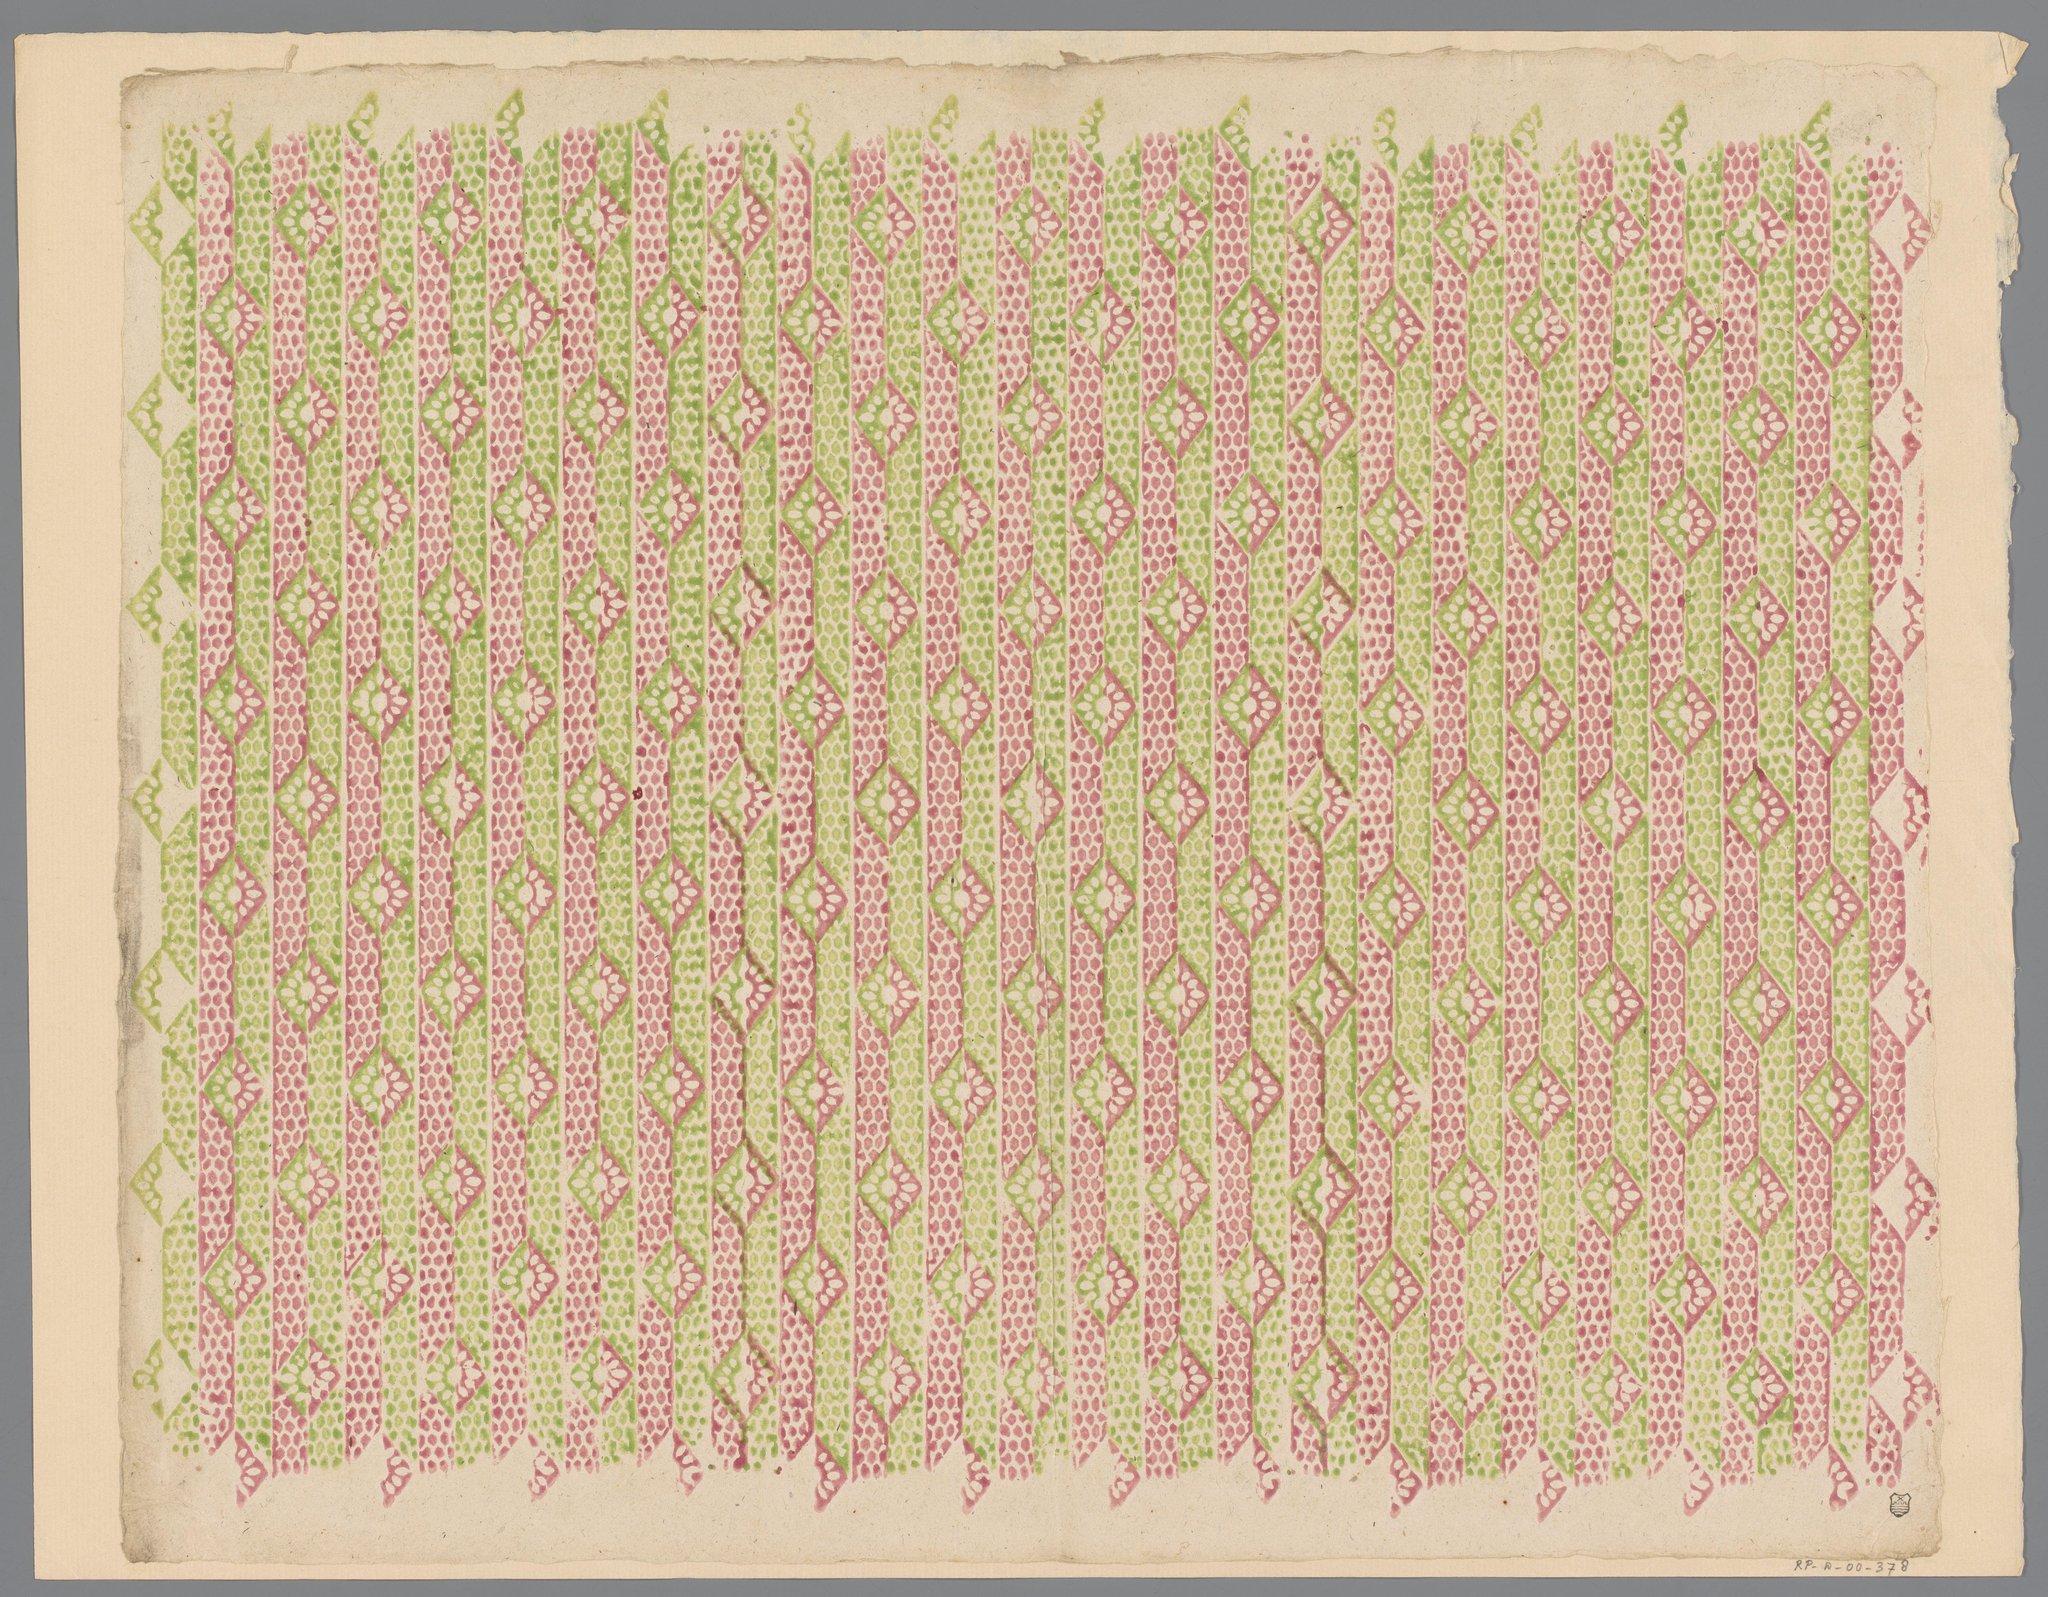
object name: printed paper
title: Blad met banenpatroon van ruiten en stippen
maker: Anonymous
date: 1700-1850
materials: paper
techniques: printing block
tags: ornament ~ geometric motifs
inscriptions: collector's mark: Lugt 2760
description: Blad met banenpatroon met geometrisch motief van ruiten en stippen in complementerende kleuren.